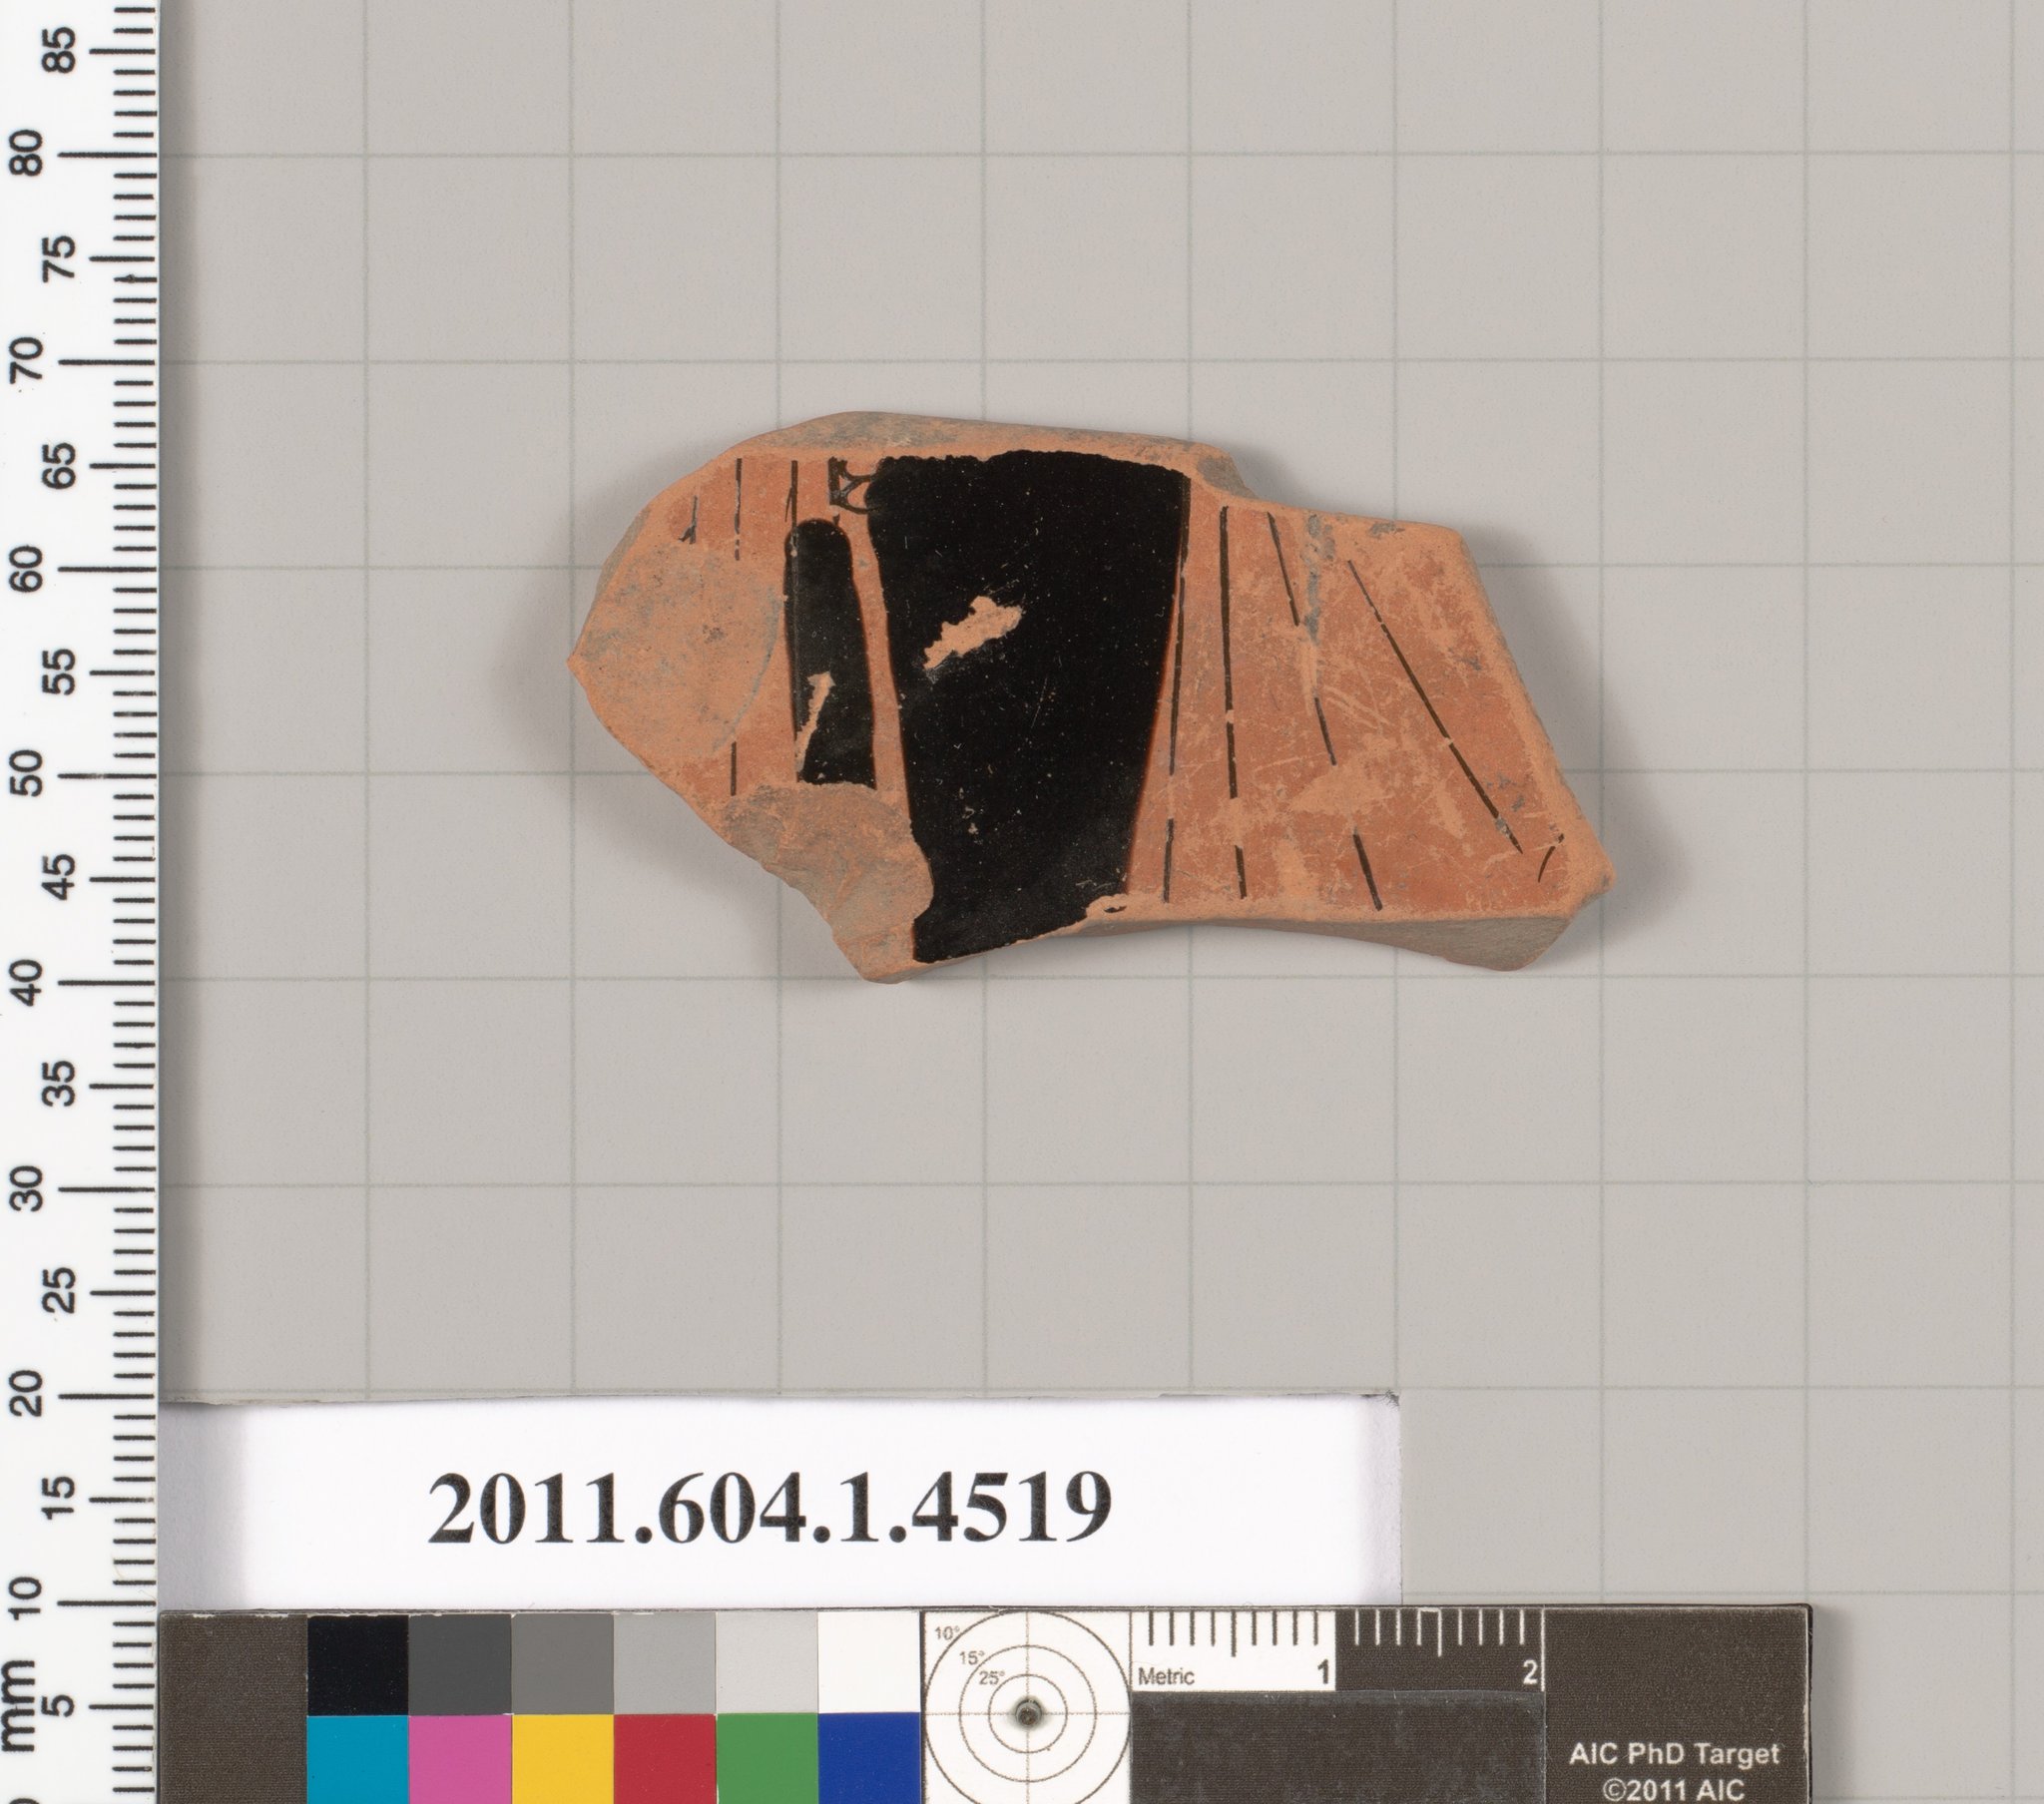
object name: kylix fragment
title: Terracotta fragment of a kylix (drinking cup)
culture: greek, attic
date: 475-451 BCE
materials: terracotta